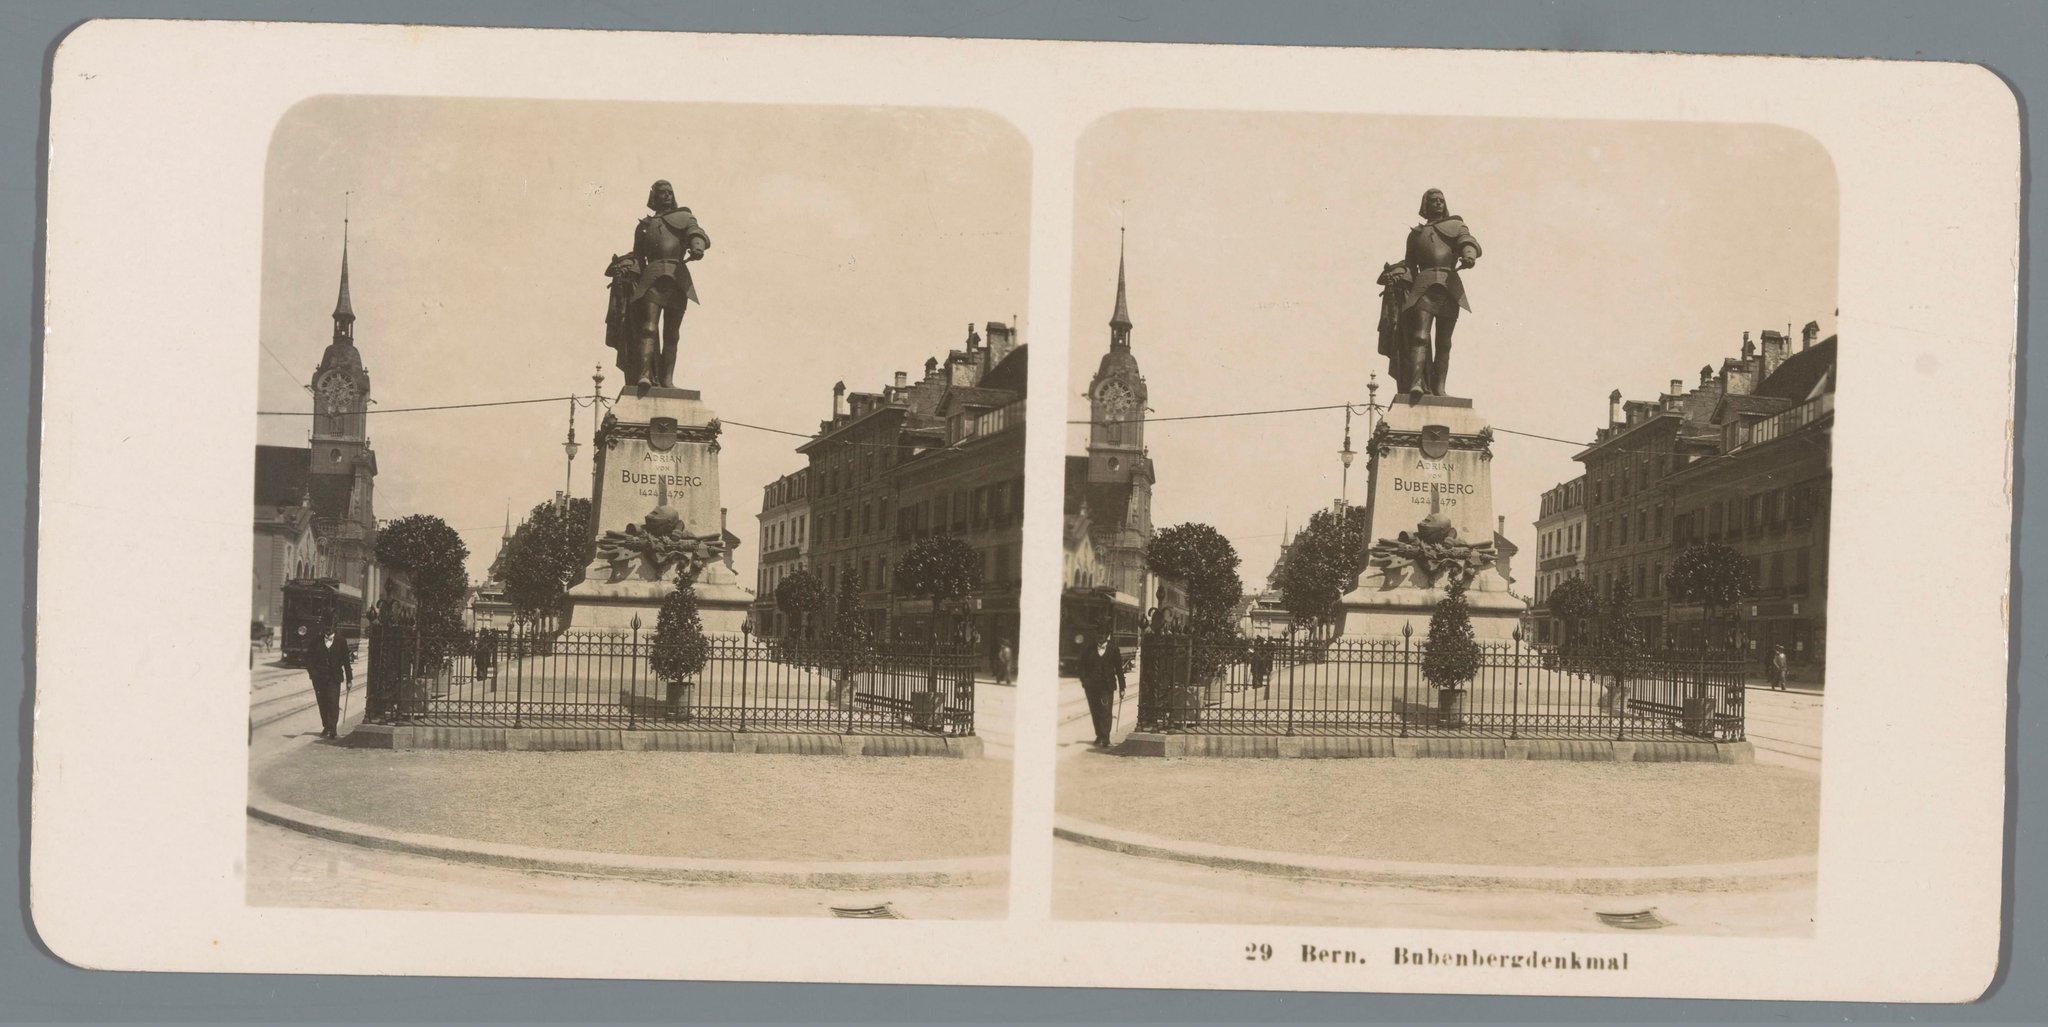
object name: stereograph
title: Bern. Bubenbergdenkmal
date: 1906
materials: cardboard, photographic support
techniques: gelatin silver print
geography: bern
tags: monument, statue, sculpture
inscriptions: inscription: ‘Neue Photographische Gesellschaft A. G., Steglitz-Berlin 1906.’, number: ‘29’